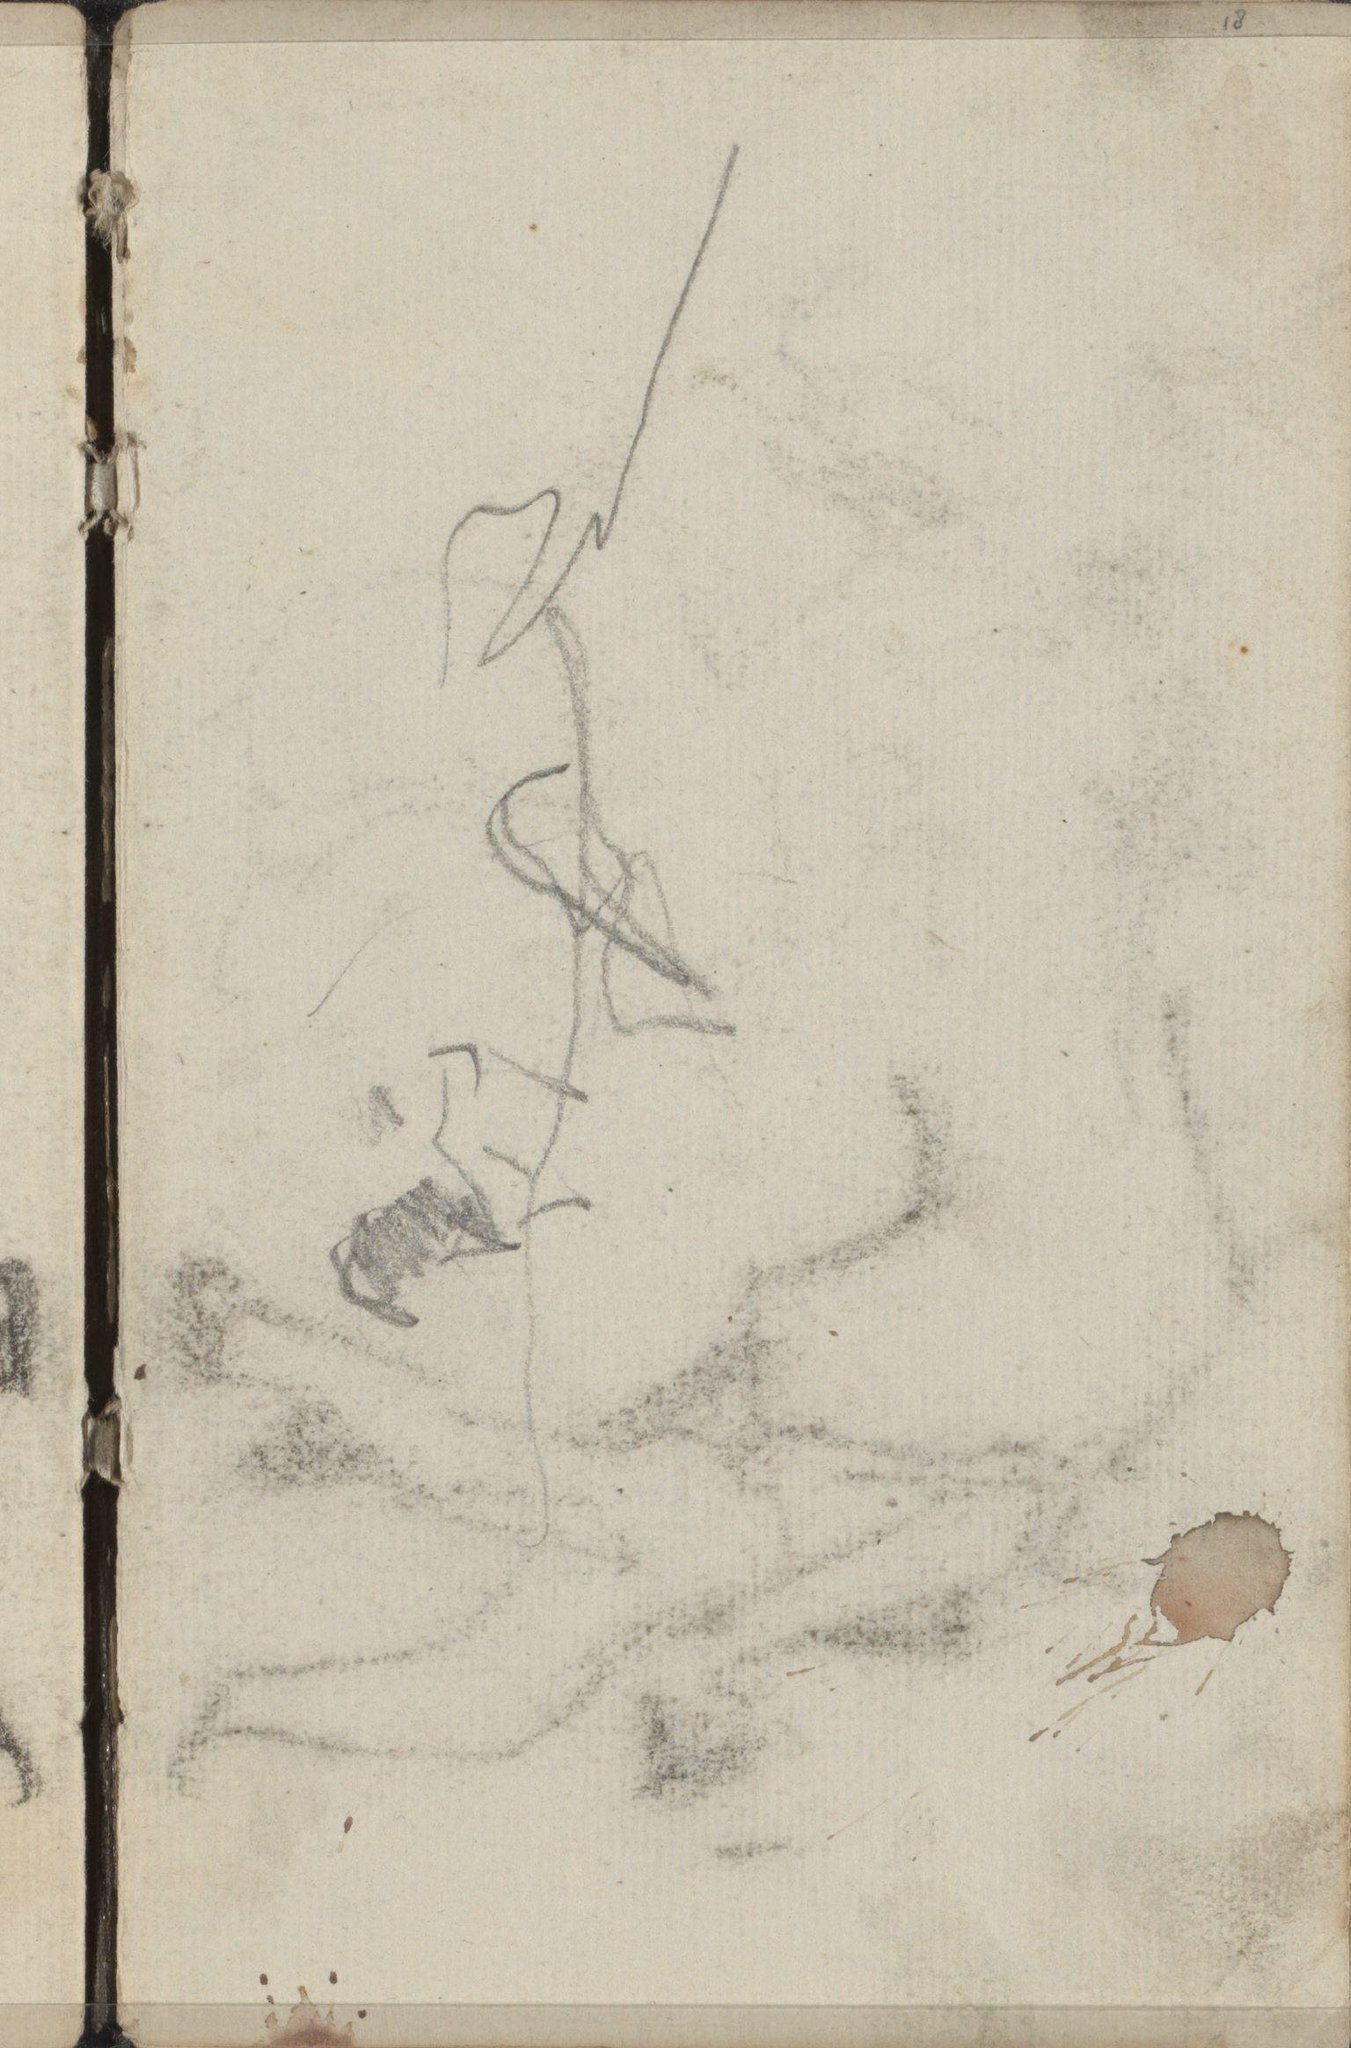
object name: sketchbook leaf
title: Studie, mogelijk van een dier in een landschap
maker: george hendrik breitner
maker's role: draughtsman, painter, print maker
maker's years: 1857-1923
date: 1883-1885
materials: paper, pencil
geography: the hague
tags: mammals, landscapes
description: Pagina 18 uit een schetsboek met 17 bladen.